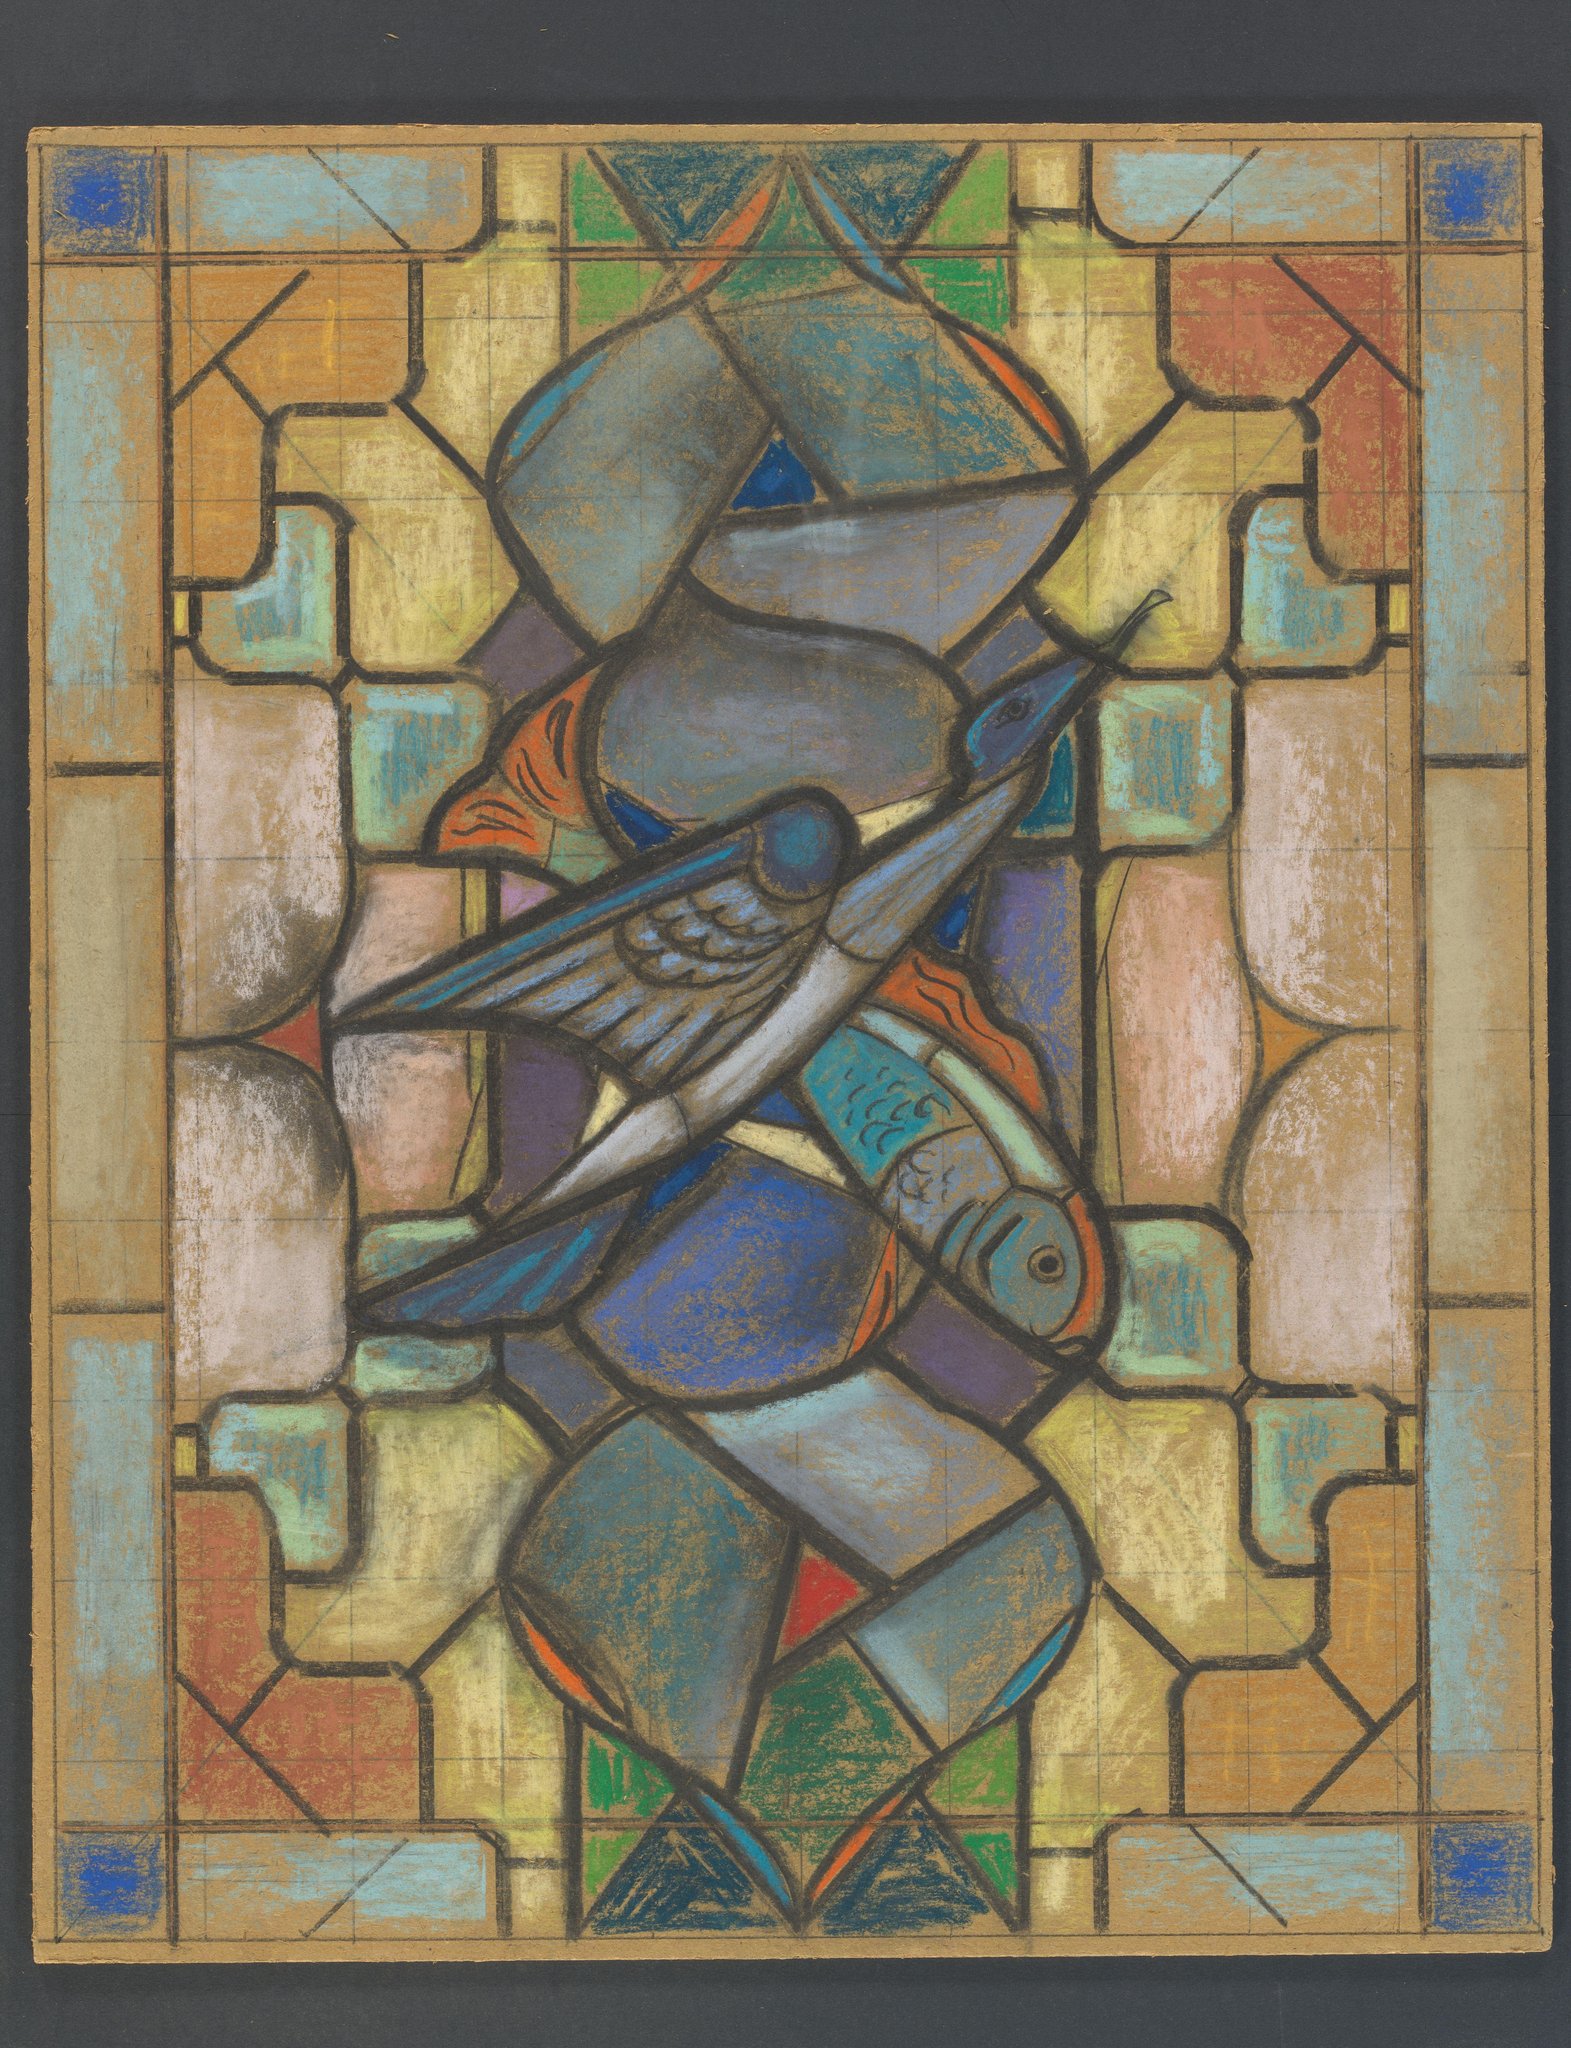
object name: design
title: Ontwerp voor een glas in loodraam met een vogel en vis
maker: jaap weyand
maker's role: draughtsman, painter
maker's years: 1886-1960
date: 1896-1934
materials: cardboard, pastel, pencil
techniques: drawing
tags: birds, fishes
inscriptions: number: ‘2’